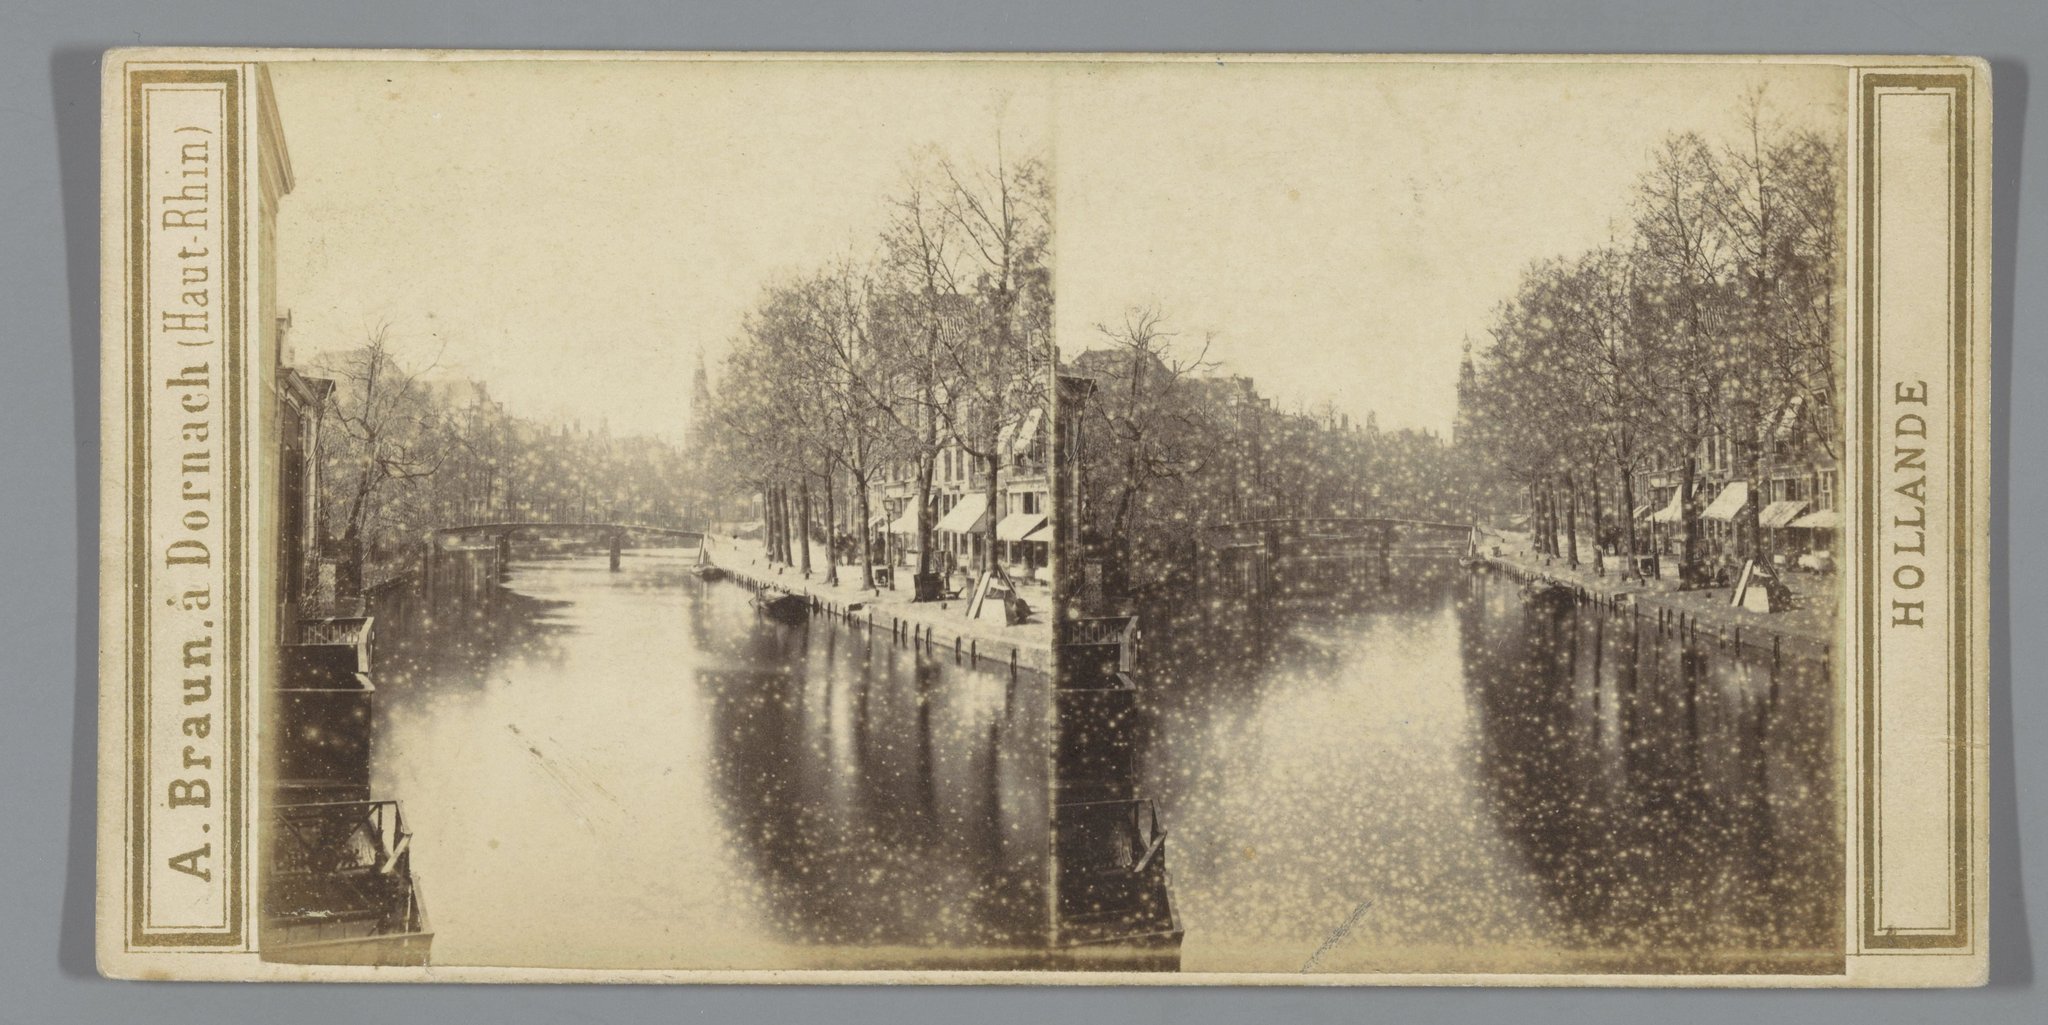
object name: stereograph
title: Nieuwe Rijn, Leiden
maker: gaston braun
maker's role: fotograaf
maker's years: 1845-1928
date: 1864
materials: cardboard, paper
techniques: albumen print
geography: nieuwe rijn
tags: canals, waters (in city)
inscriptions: inscription: ‘Nederland’, number: ‘No 3872.’